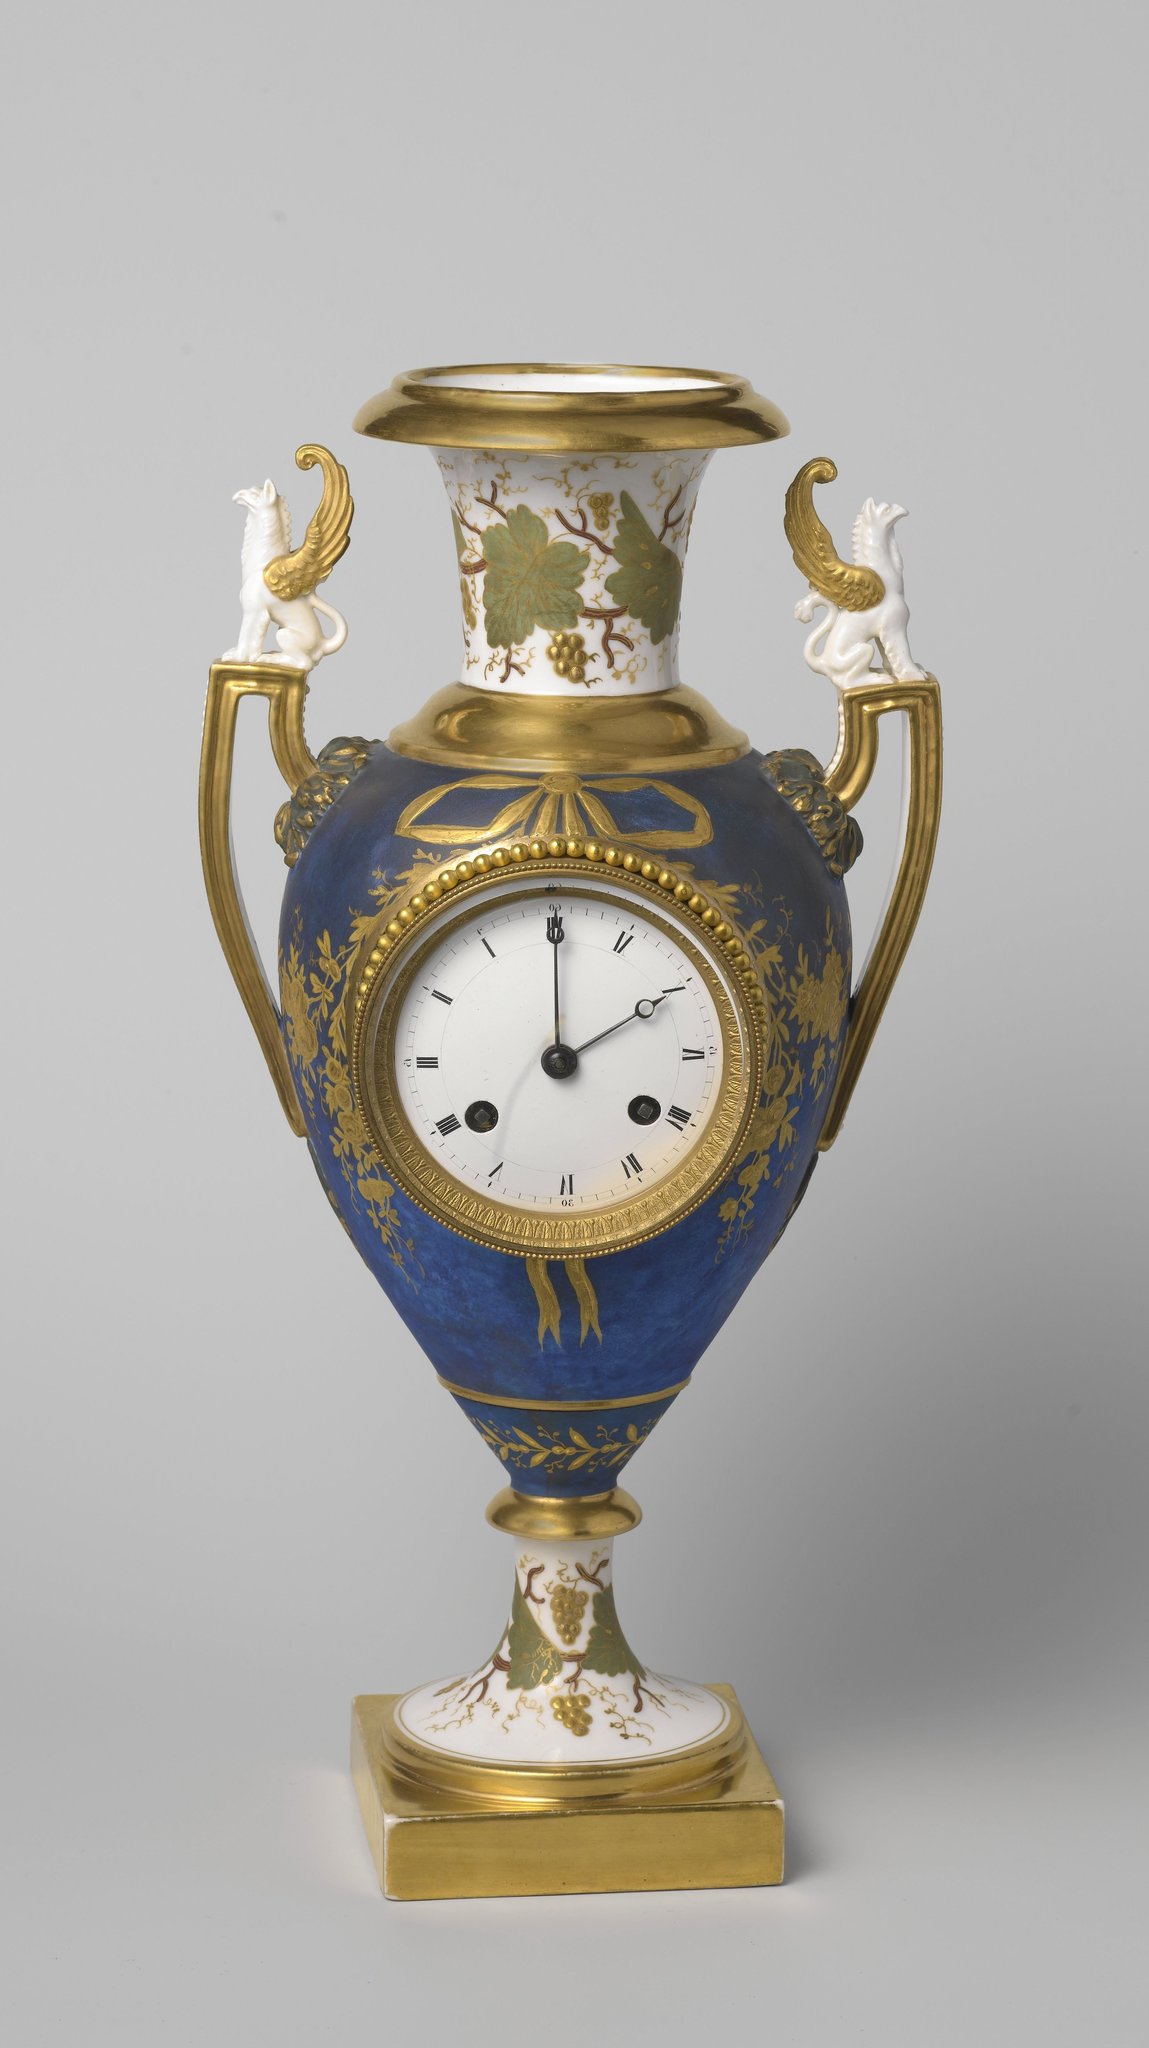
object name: mechanical clock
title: Vase with a clock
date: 1809-1814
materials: porcelain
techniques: painted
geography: nieuwer-amstel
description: Koninklijke Porseleinfabriek Dommer & Co. Nieuwer-Amstel, c. 1809–1814 hard-paste porcelain, brass, enamel